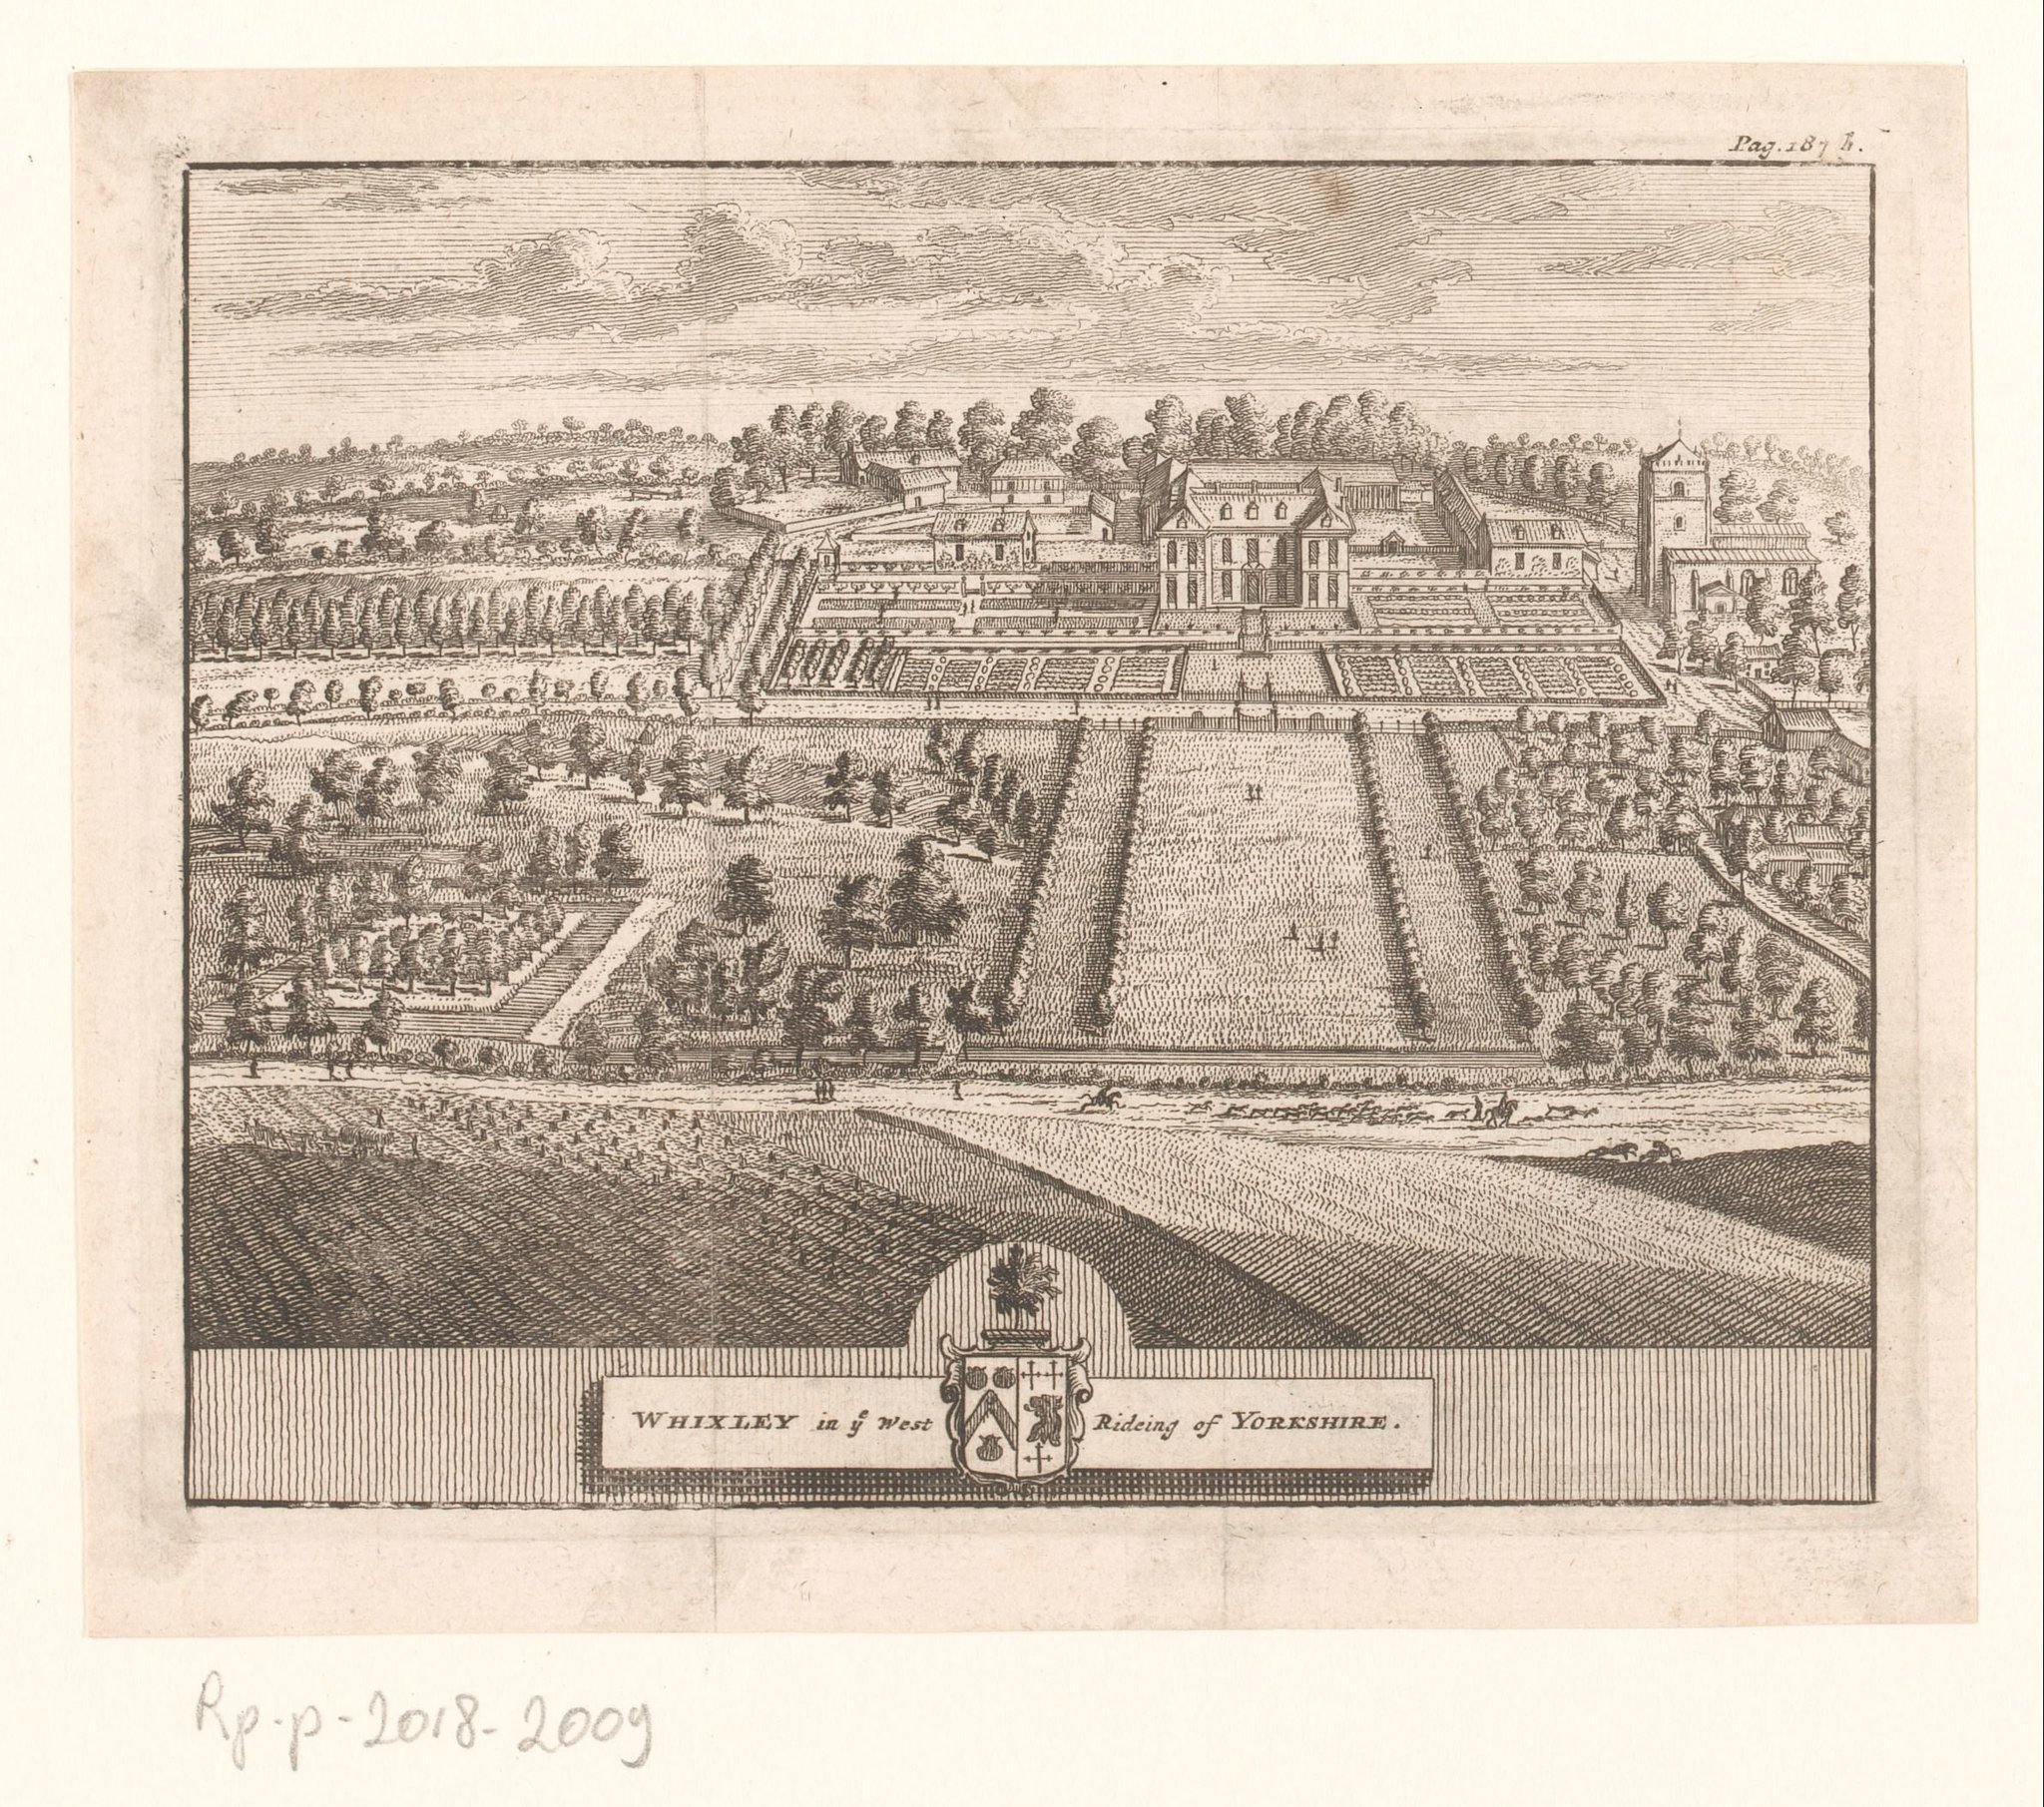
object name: print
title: Gezicht op Allerton Castle, bij Whixley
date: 1707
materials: paper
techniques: etching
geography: leiden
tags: castle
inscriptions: collector's mark: Lugt 2228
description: Prent gebruikt in: Beeverell, James. Les Delices de la Grande Bretagne et de l'Irlande (...). Leiden: Pieter van der Aa, 1707.